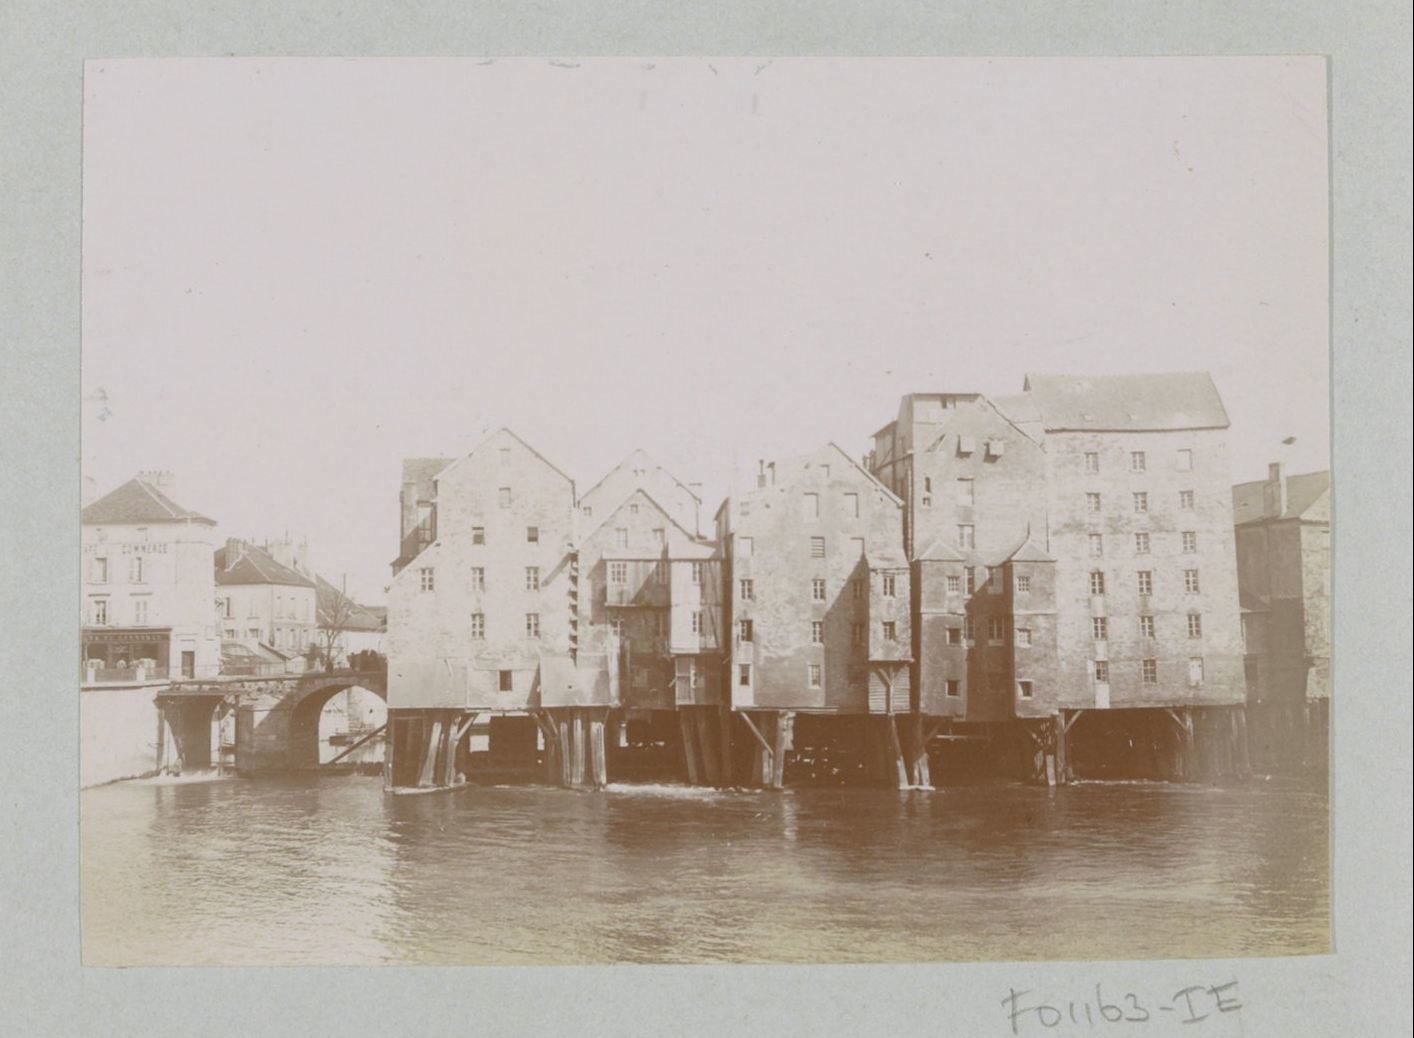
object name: photograph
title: Gezicht op watermolens in Meaux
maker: delizy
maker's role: manufacturer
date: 1804-1899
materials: paper, photographic support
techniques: gelatin silver print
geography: meaux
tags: watermill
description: Onderdeel van Fotoalbum van een Franse amateurfotograaf met opnames van uitstapjes in Frankrijk, Spanje, België, Luxemburg en Nederland, de eerste automobielen en autoraces.